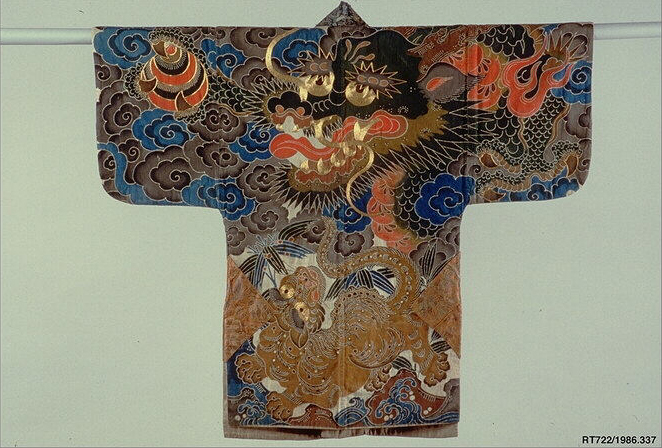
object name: festival coat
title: Festival coat with dragon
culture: japanese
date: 1868-1912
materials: cotton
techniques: dyeing, painting, resist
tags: dragons,tigers,waves